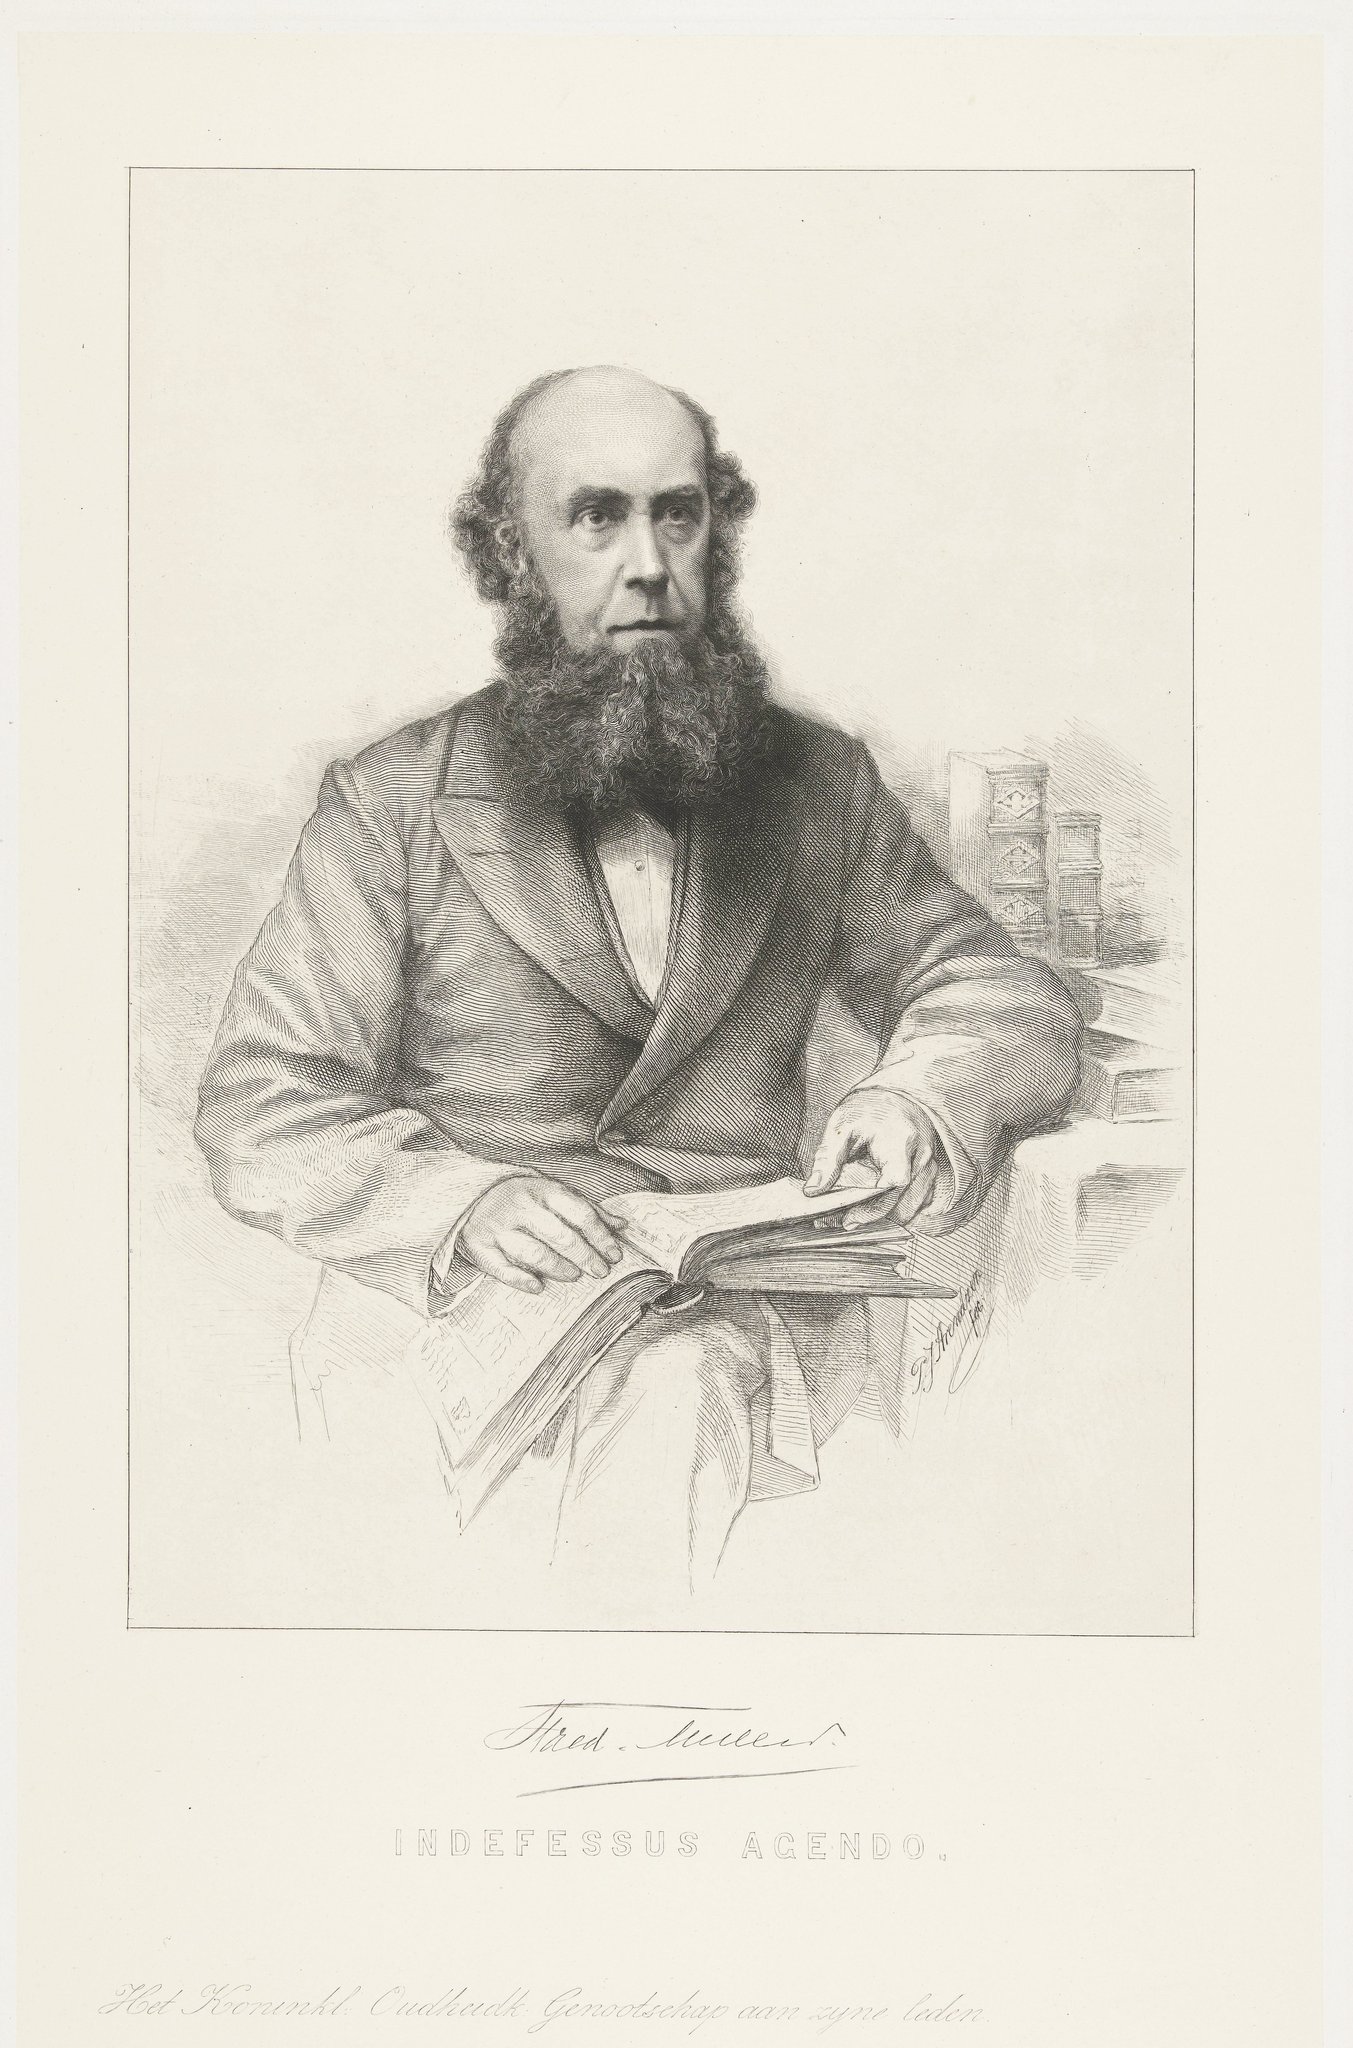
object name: print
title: Portret van Frederik Muller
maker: petrus johannes arendzen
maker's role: draughtsman, print maker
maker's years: 1846-1932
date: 1879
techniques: printmaking, drypoint, etching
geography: netherlands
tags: bookseller, frederik muller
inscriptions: collector's mark: Lugt 2228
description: Portret van Frederik Muller op 62 jarige leeftijd, bij een tafel met boeken. Onder het portret zijn handtekening in facsimile en het motto: Indefessus agendo. Door het Koninklijk Oudheidkundig Genootschap aangeboden aan zijne leden.